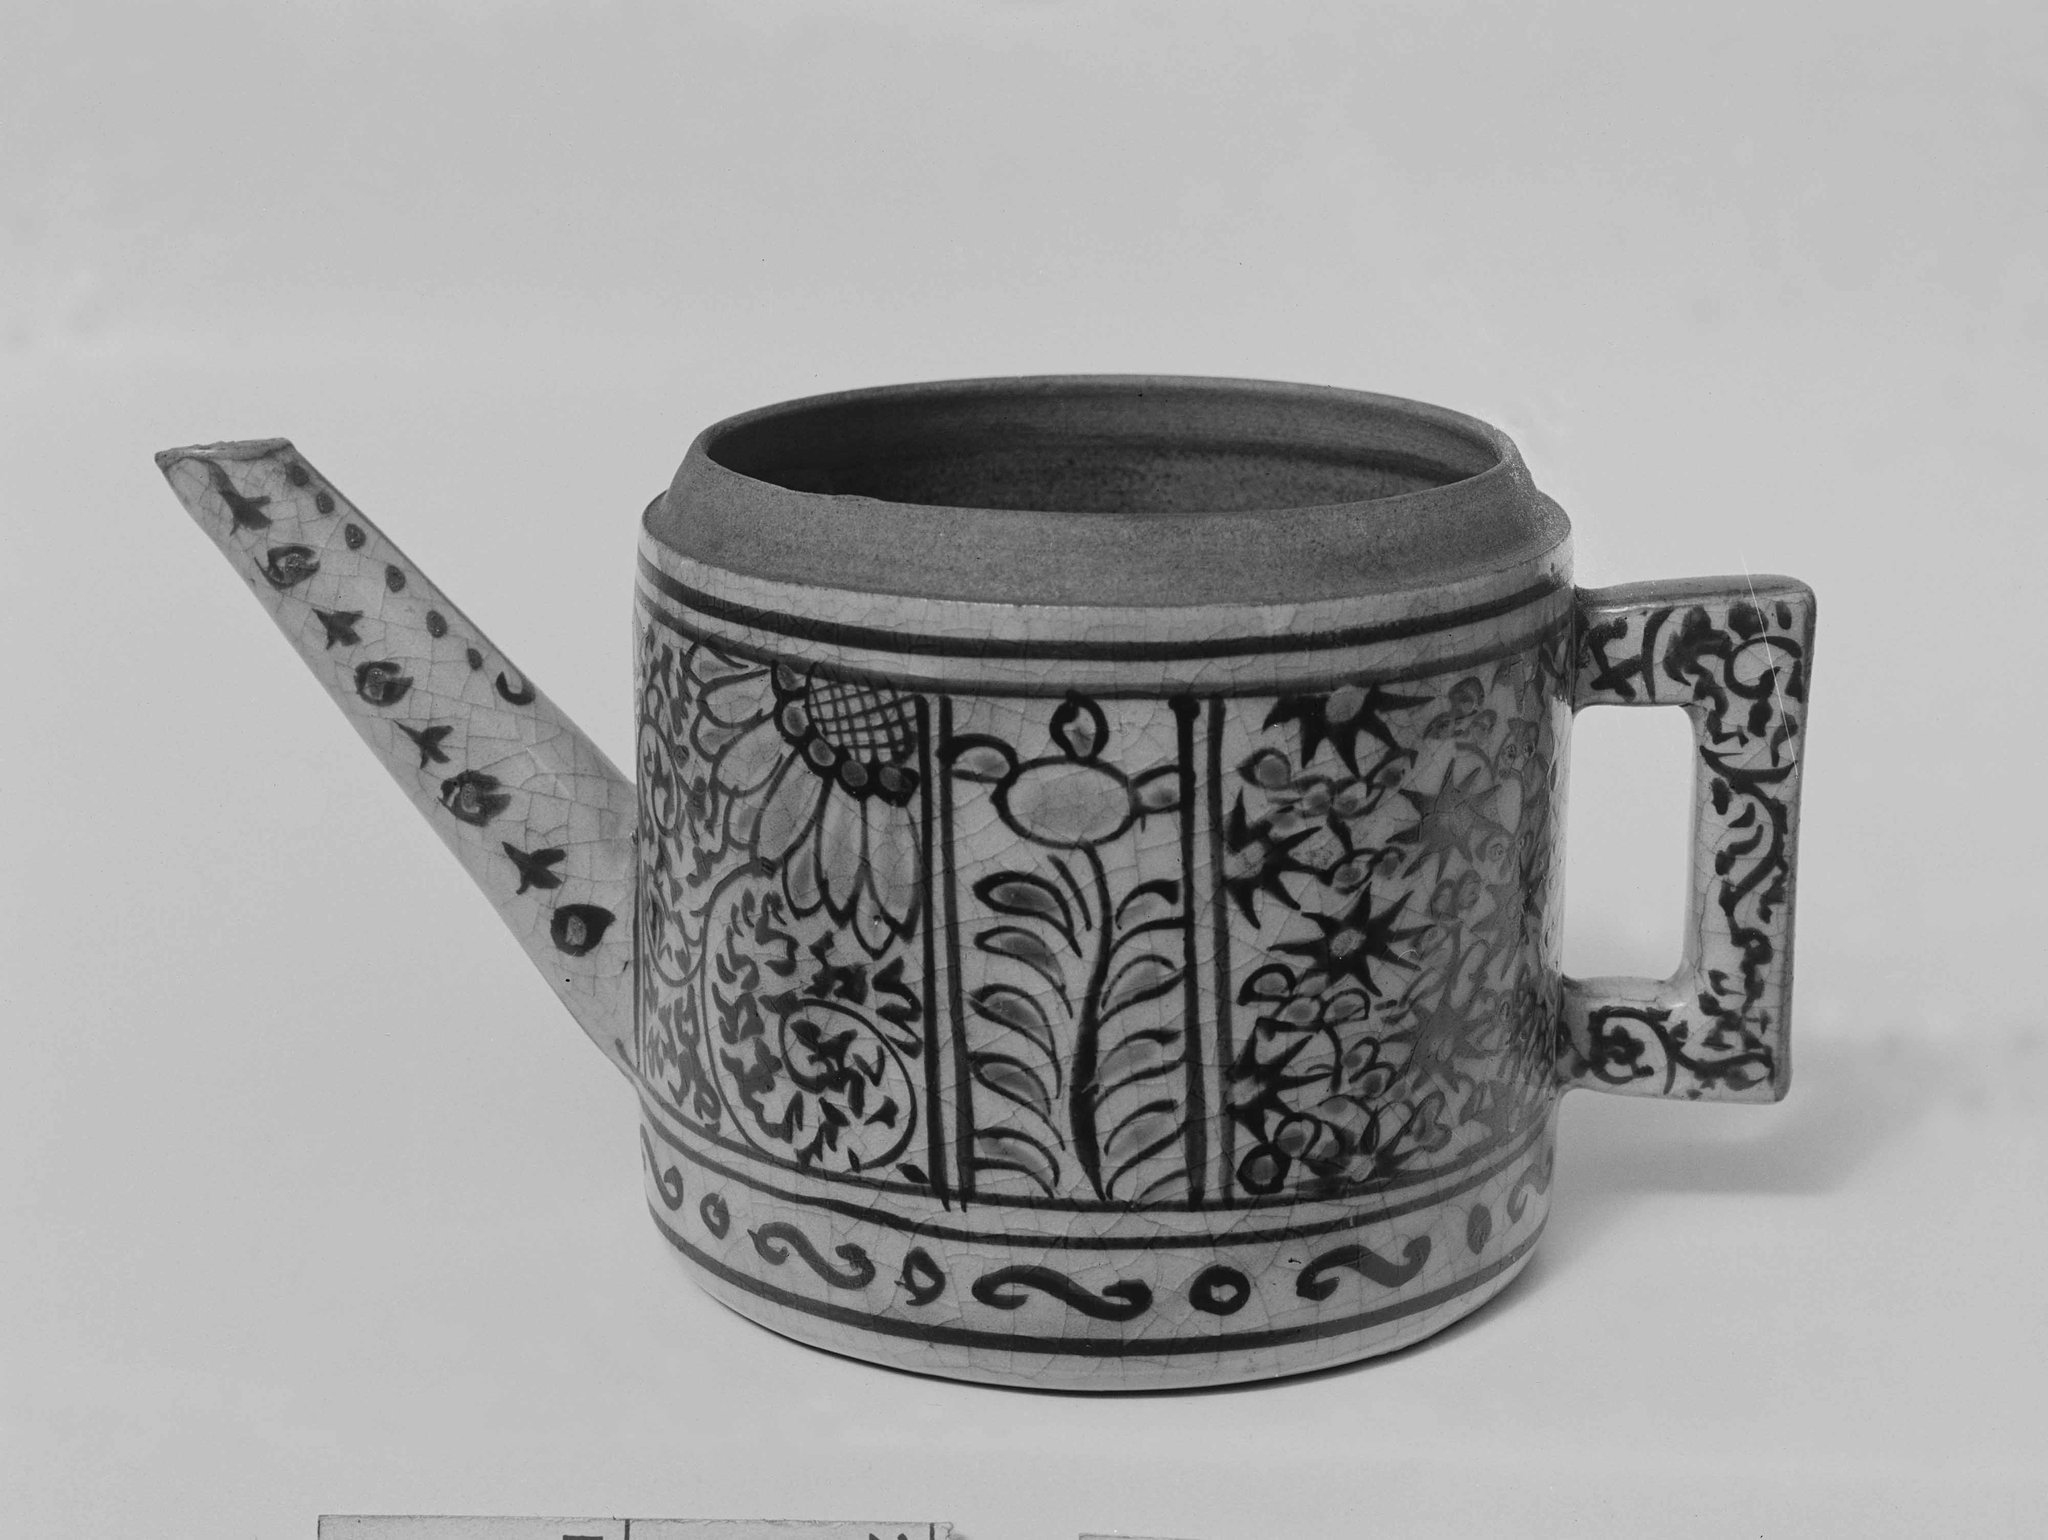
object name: teapot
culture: japanese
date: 1801-1900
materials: earthenware